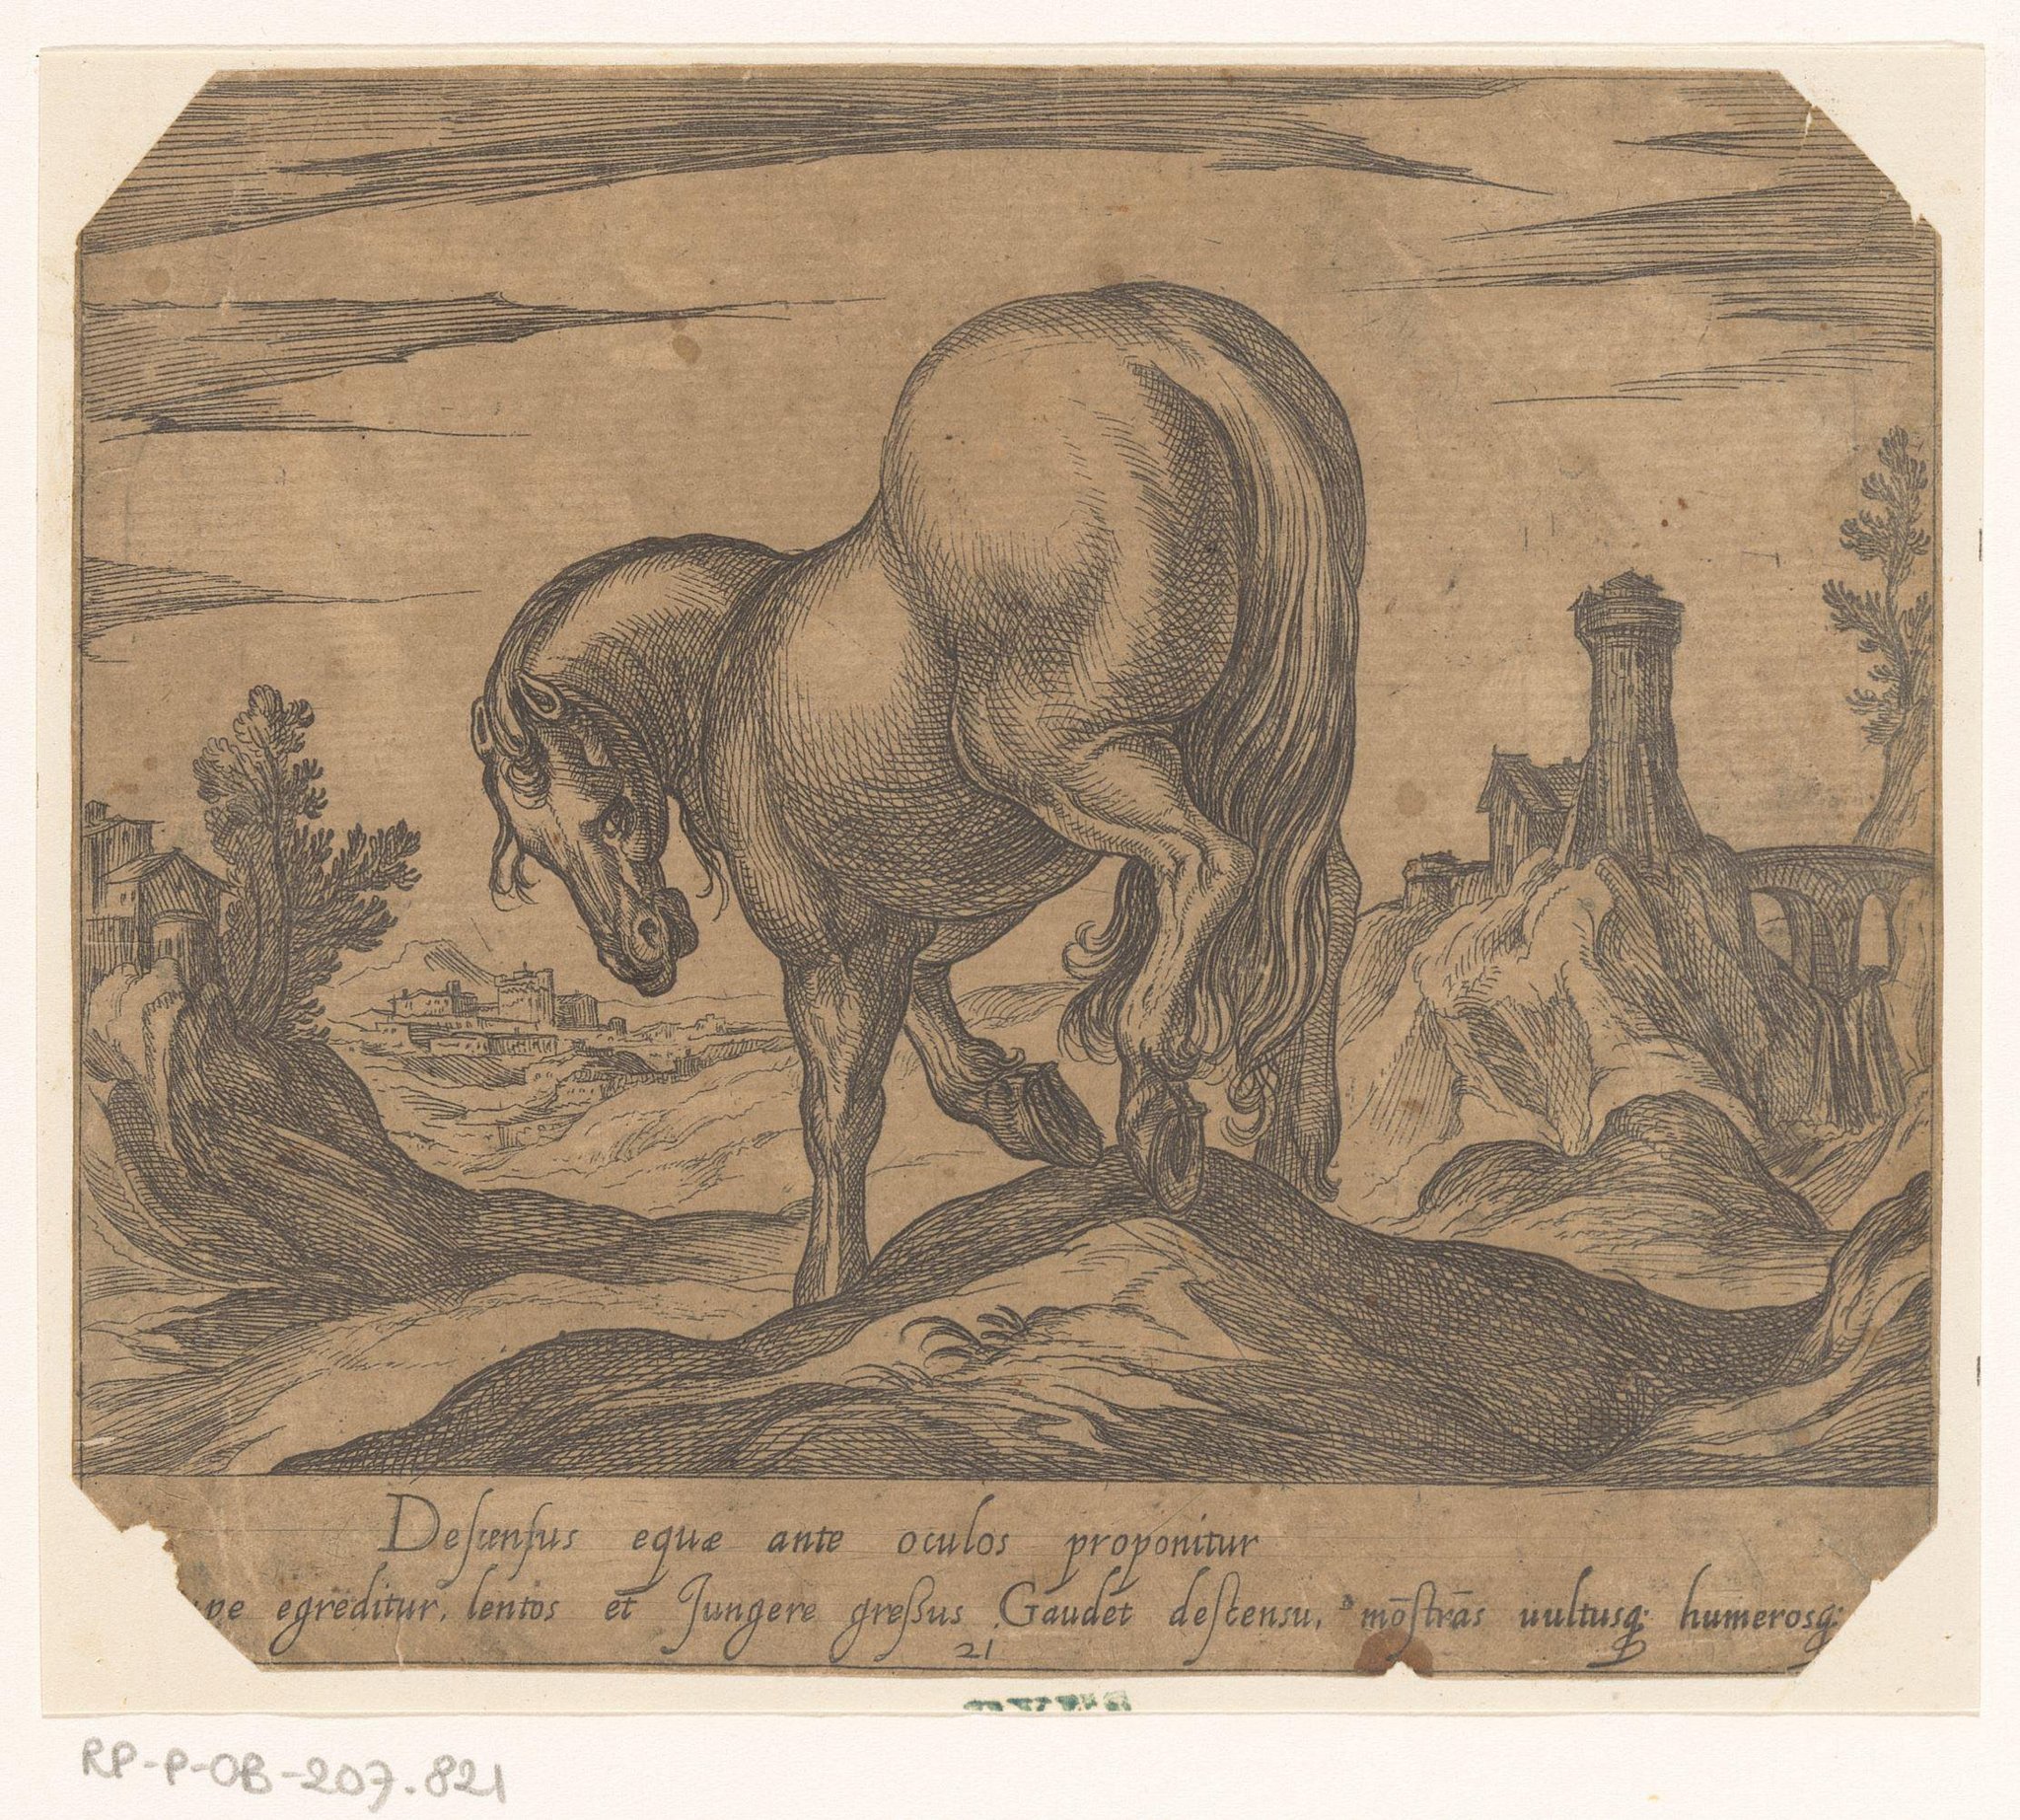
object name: print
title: Paarden uit verschillende landen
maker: antonio tempesta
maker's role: draughtsman, painter, print maker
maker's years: 1555-1630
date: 1590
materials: paper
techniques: etching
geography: italy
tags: horse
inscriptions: collector's mark: Lugt 2228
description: Deze prent maakt deel uit van een reeks van 28 prenten van paarden (+ titelprent en opdracht).